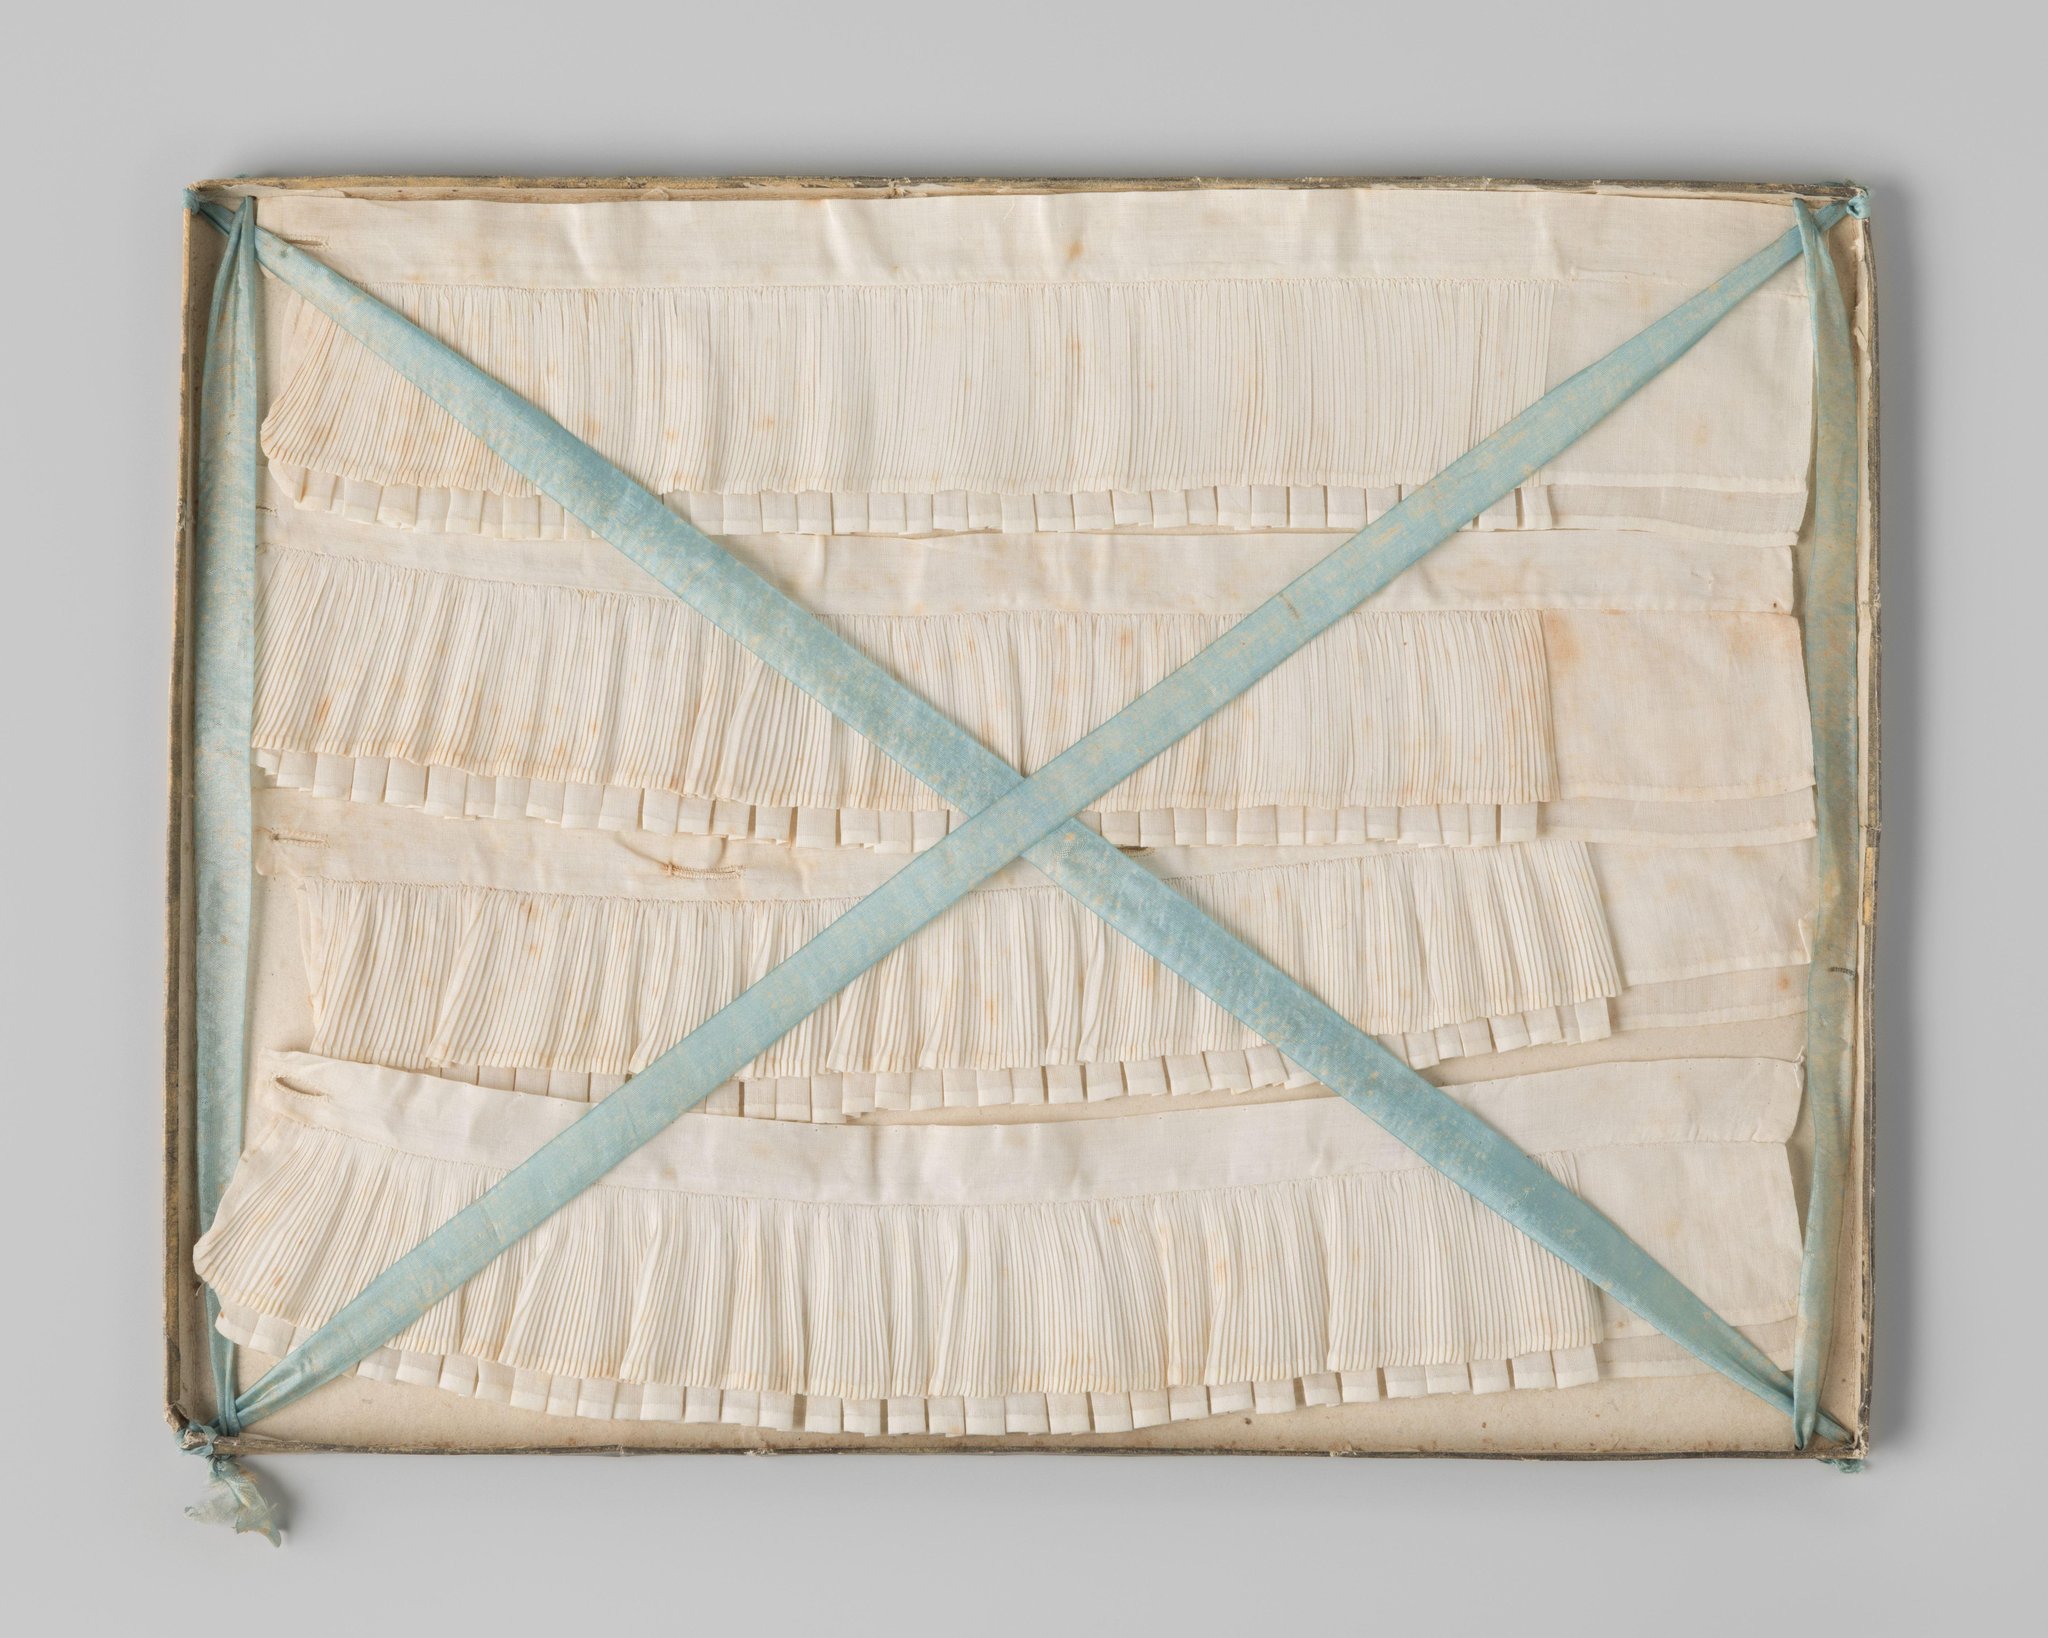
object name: menswear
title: Four jabots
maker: Anonymous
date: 1800-1810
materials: linen, paper, silk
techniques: weave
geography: netherlands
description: Jabots are ruffles attached – as extra decoration – to the vertical split at the centre front of a man’s shirt. Rarely have articles of clothing or accessories come down to us unused and in their original packaging. These jabots have been preserved because the family had a large house with an attic and great regard for (family) history.